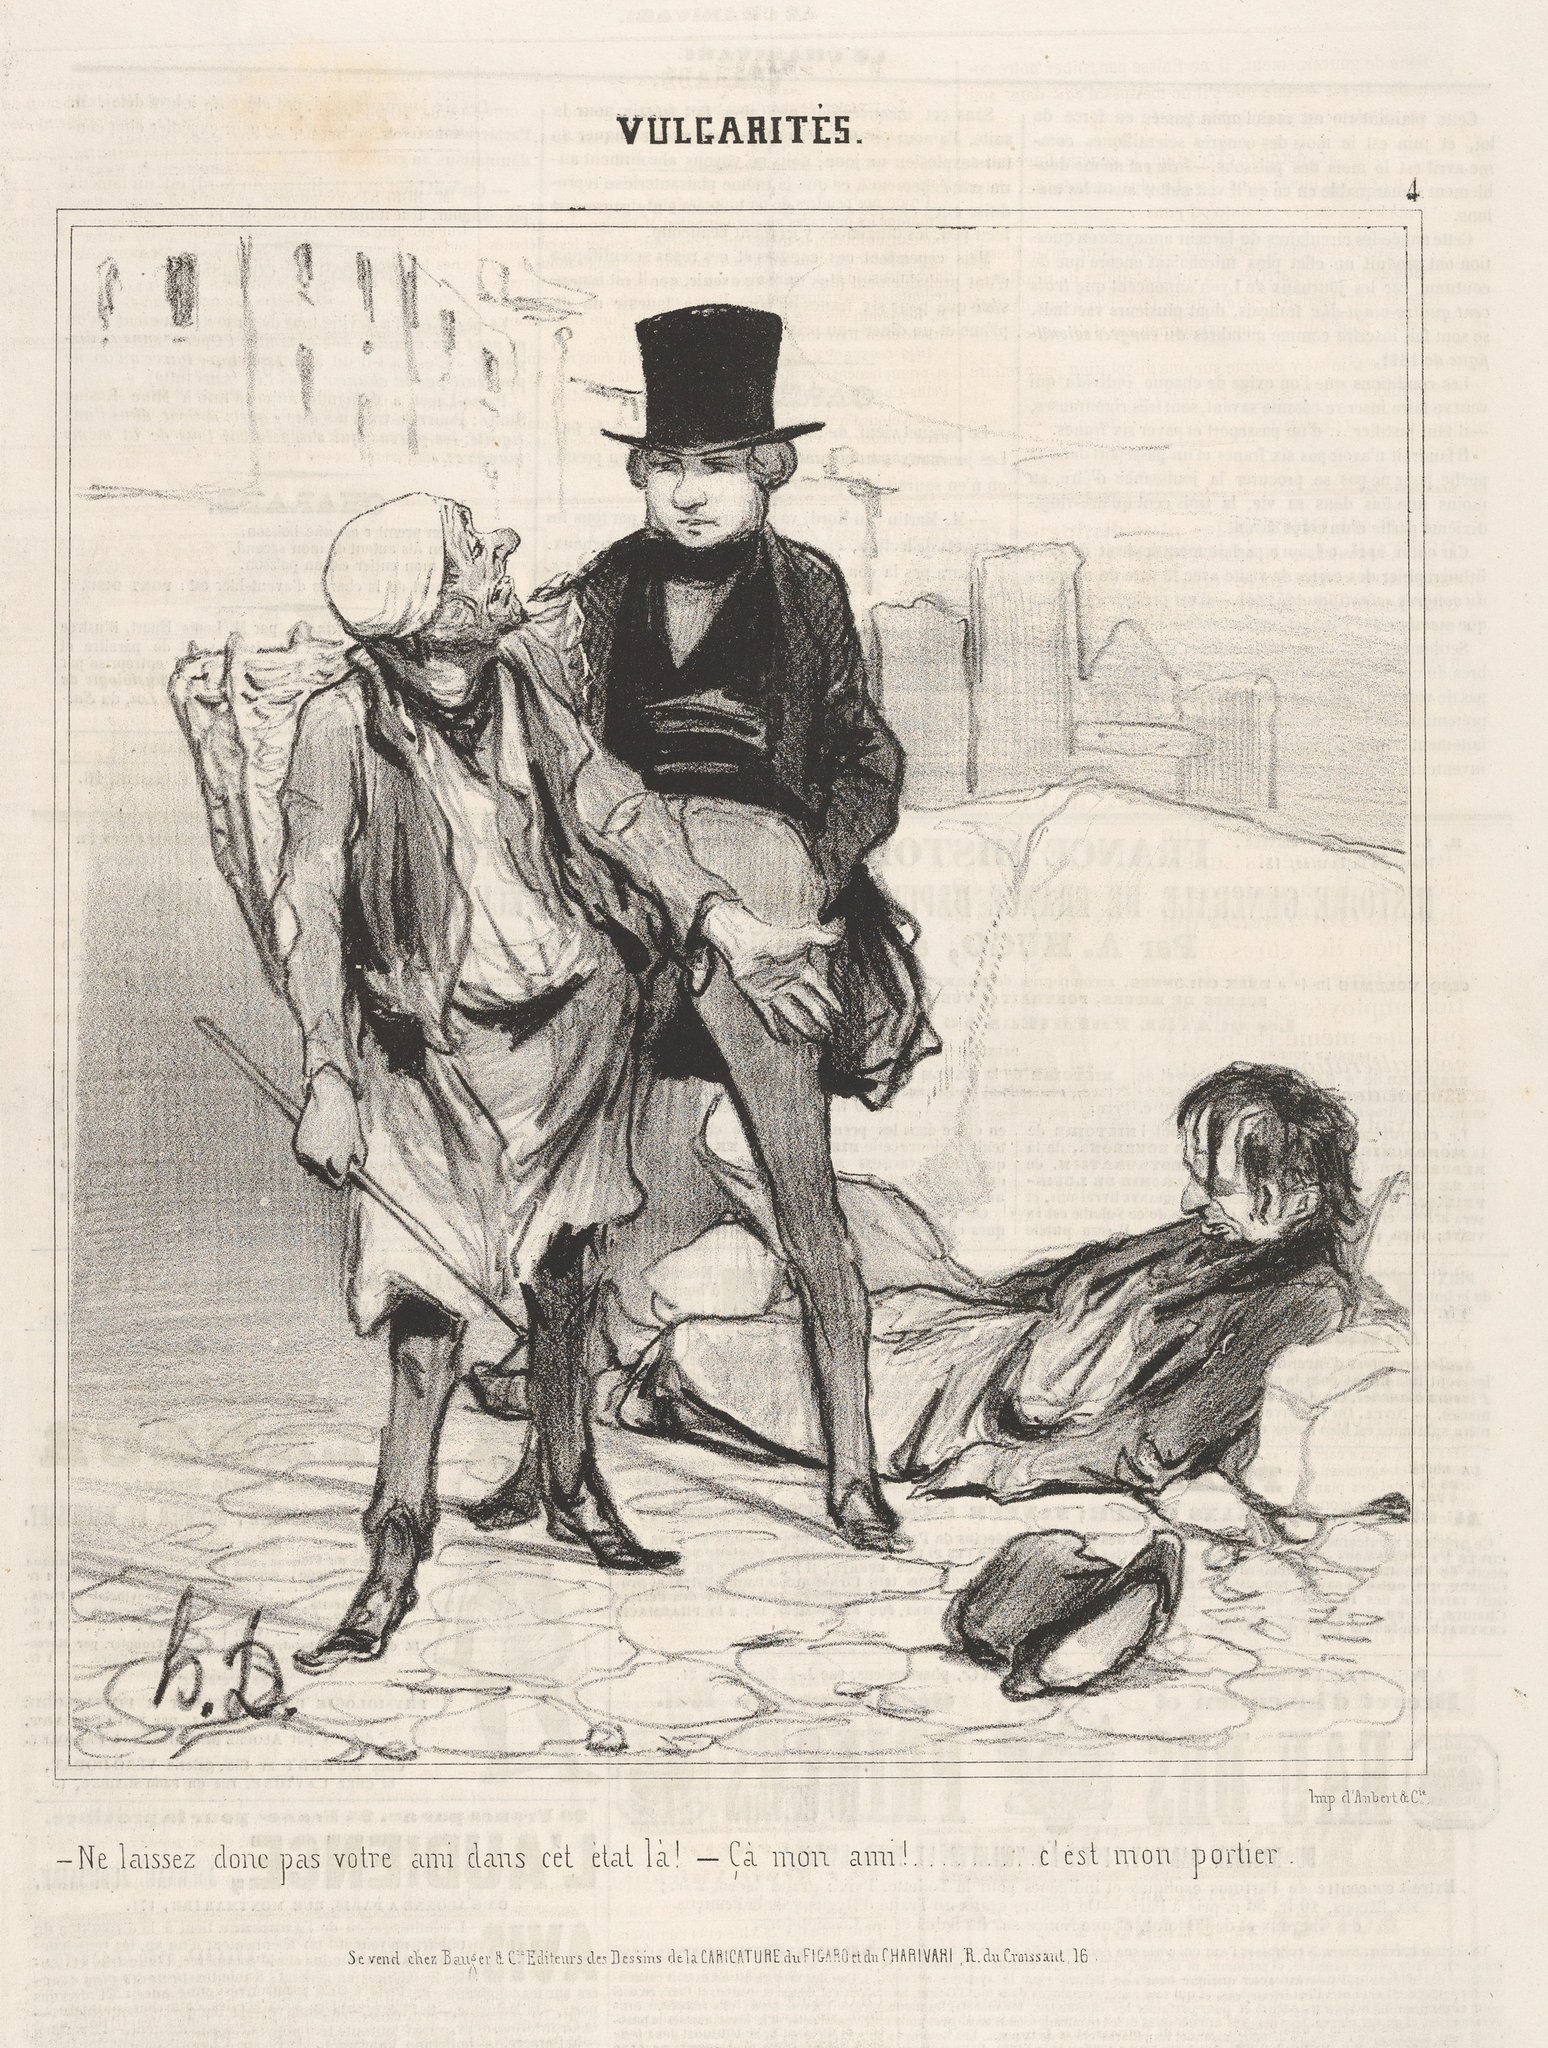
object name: print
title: Ne laissez donc pas vôtre ami dans cet état-là!..., plate 4 from "Vulgarités"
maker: honoré daumier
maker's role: artist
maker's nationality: french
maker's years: 1808-1879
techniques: lithograph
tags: men